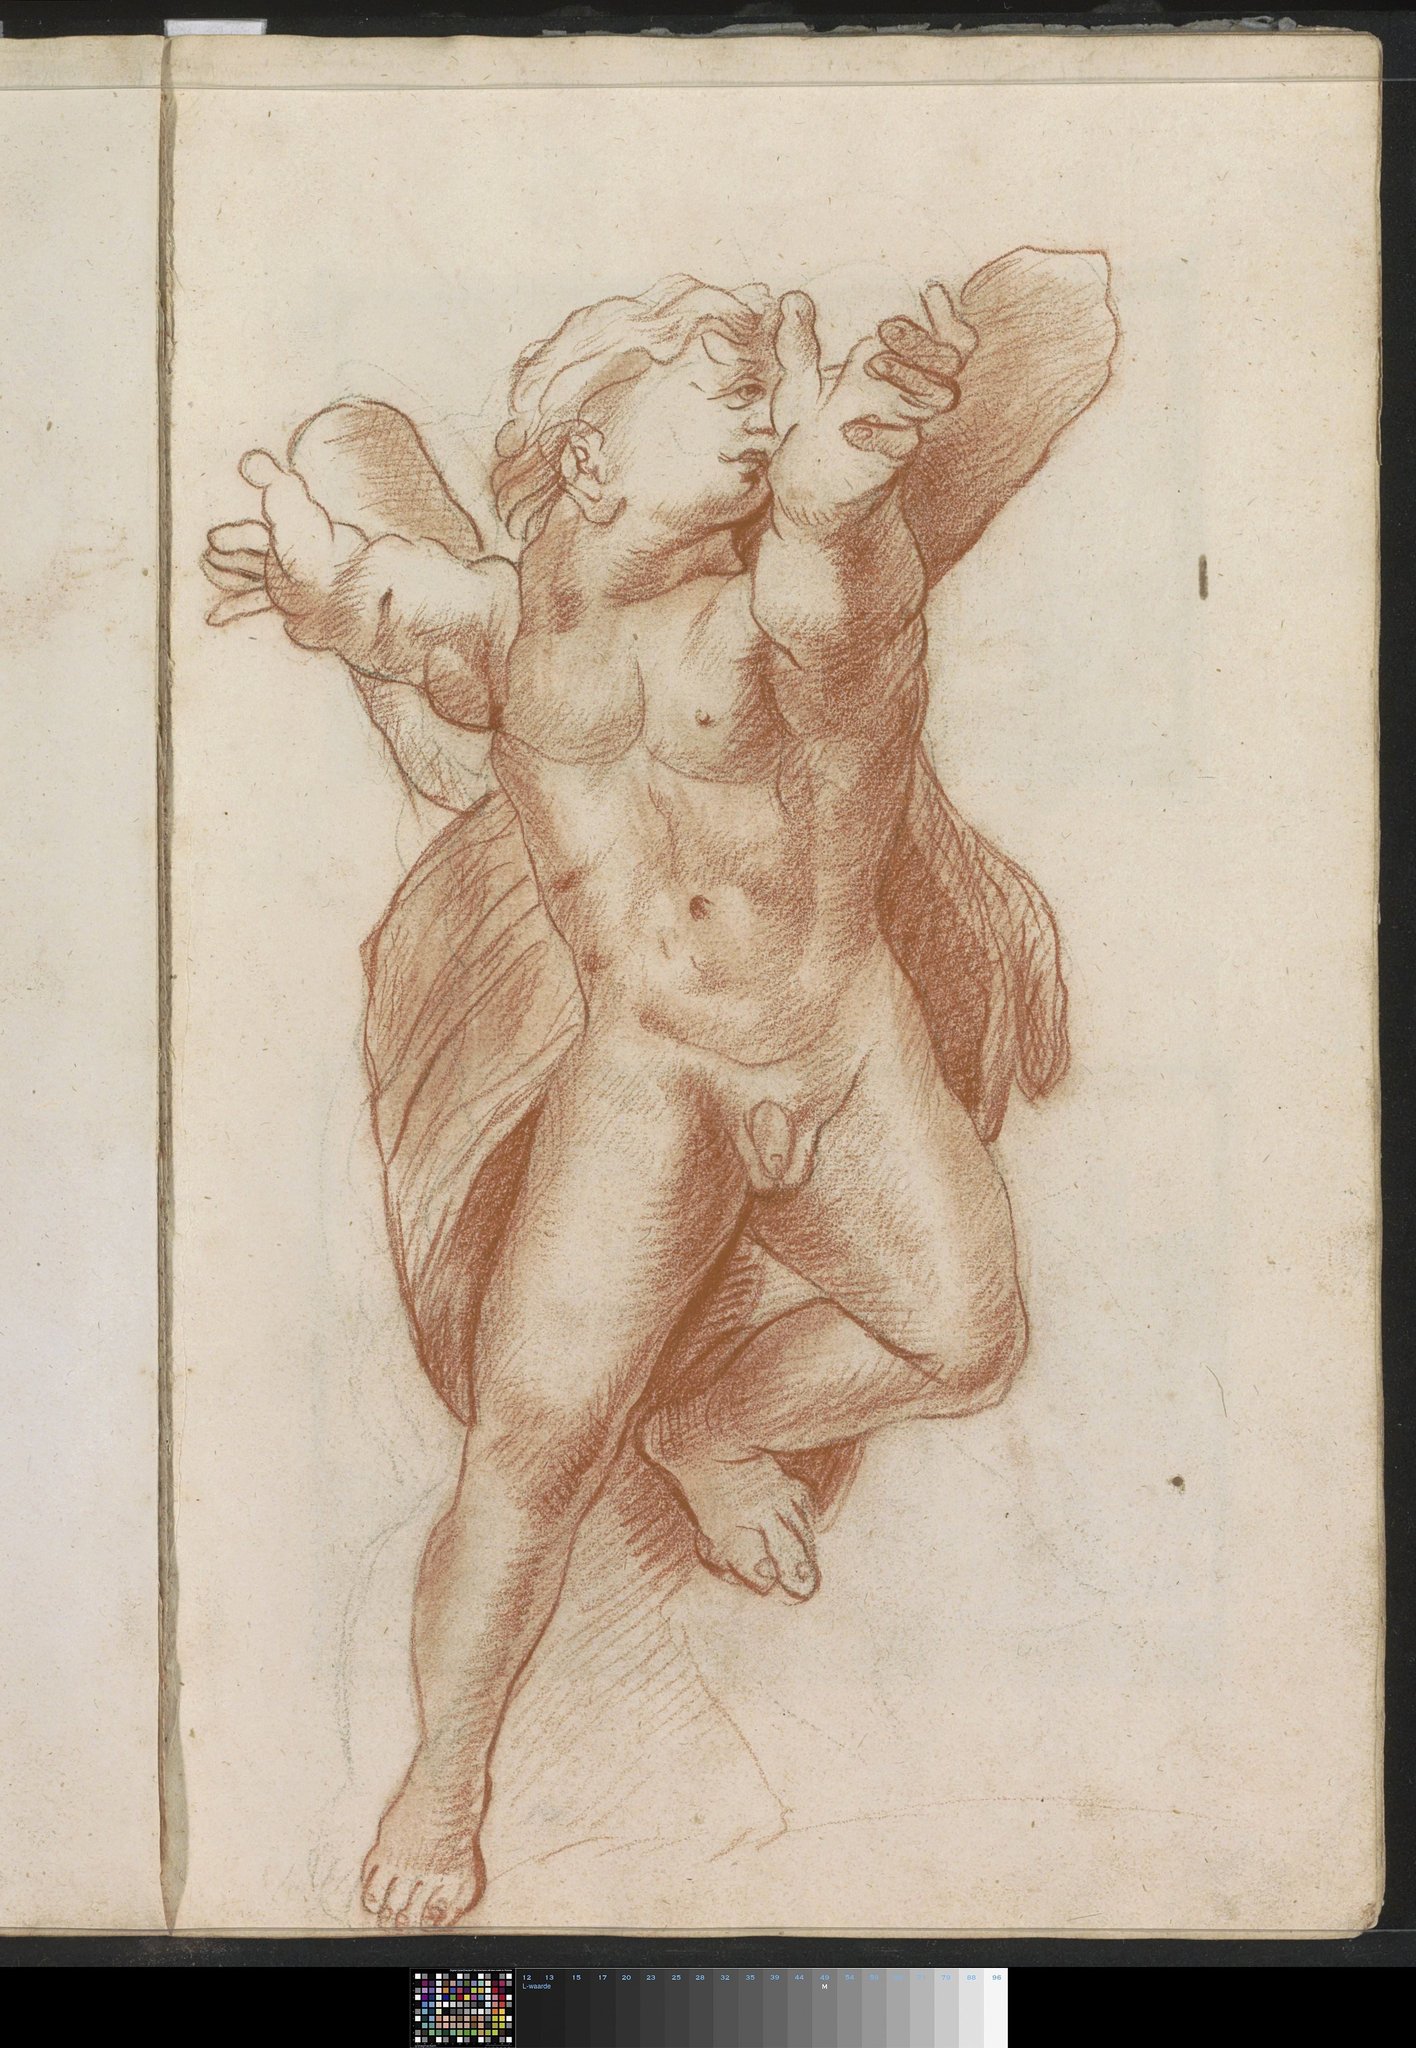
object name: sketchbook leaf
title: Straf van Haman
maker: hendrick van beaumont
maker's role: draughtsman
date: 1696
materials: chalk, paper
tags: haman on the gallows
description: Blad 69 recto uit een schetsboek met 91 bladen.